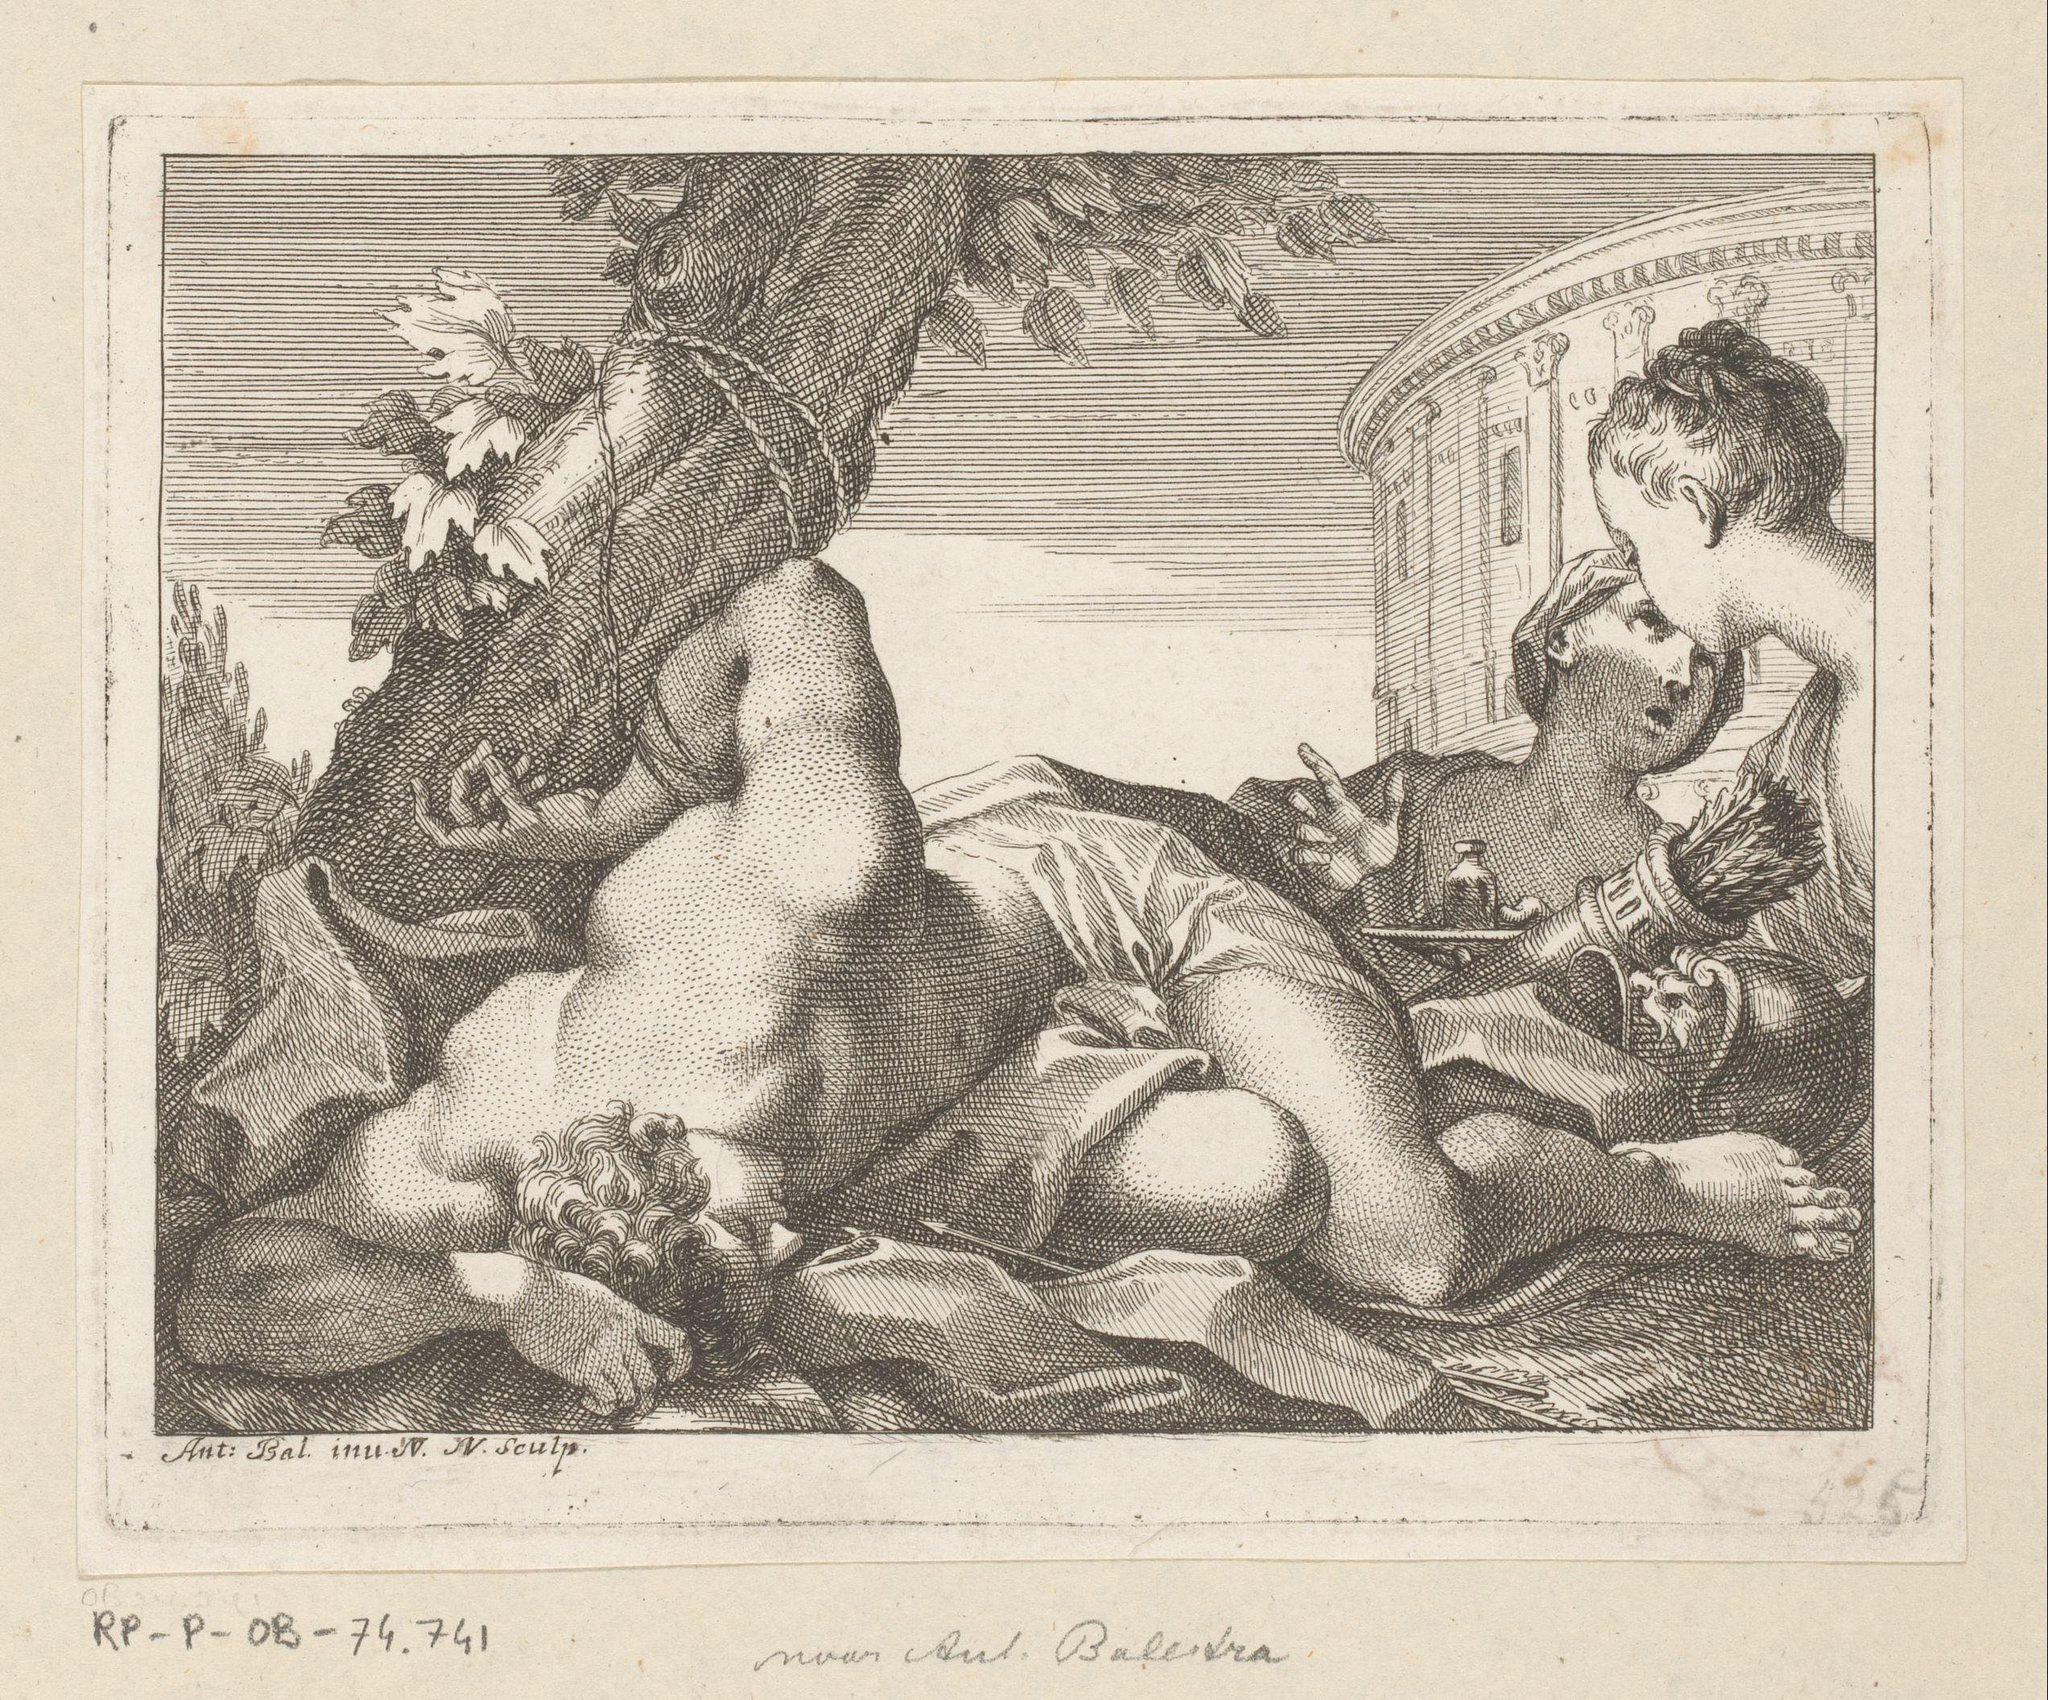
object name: print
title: H. Sebastiaan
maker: antonio balestra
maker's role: print maker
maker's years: 1666-1740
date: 1717-1762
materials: paper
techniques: engraving, etching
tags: st. sebastian, tied to a tree or a pillar, is pierced by arrows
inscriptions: collector's mark: Lugt 2228